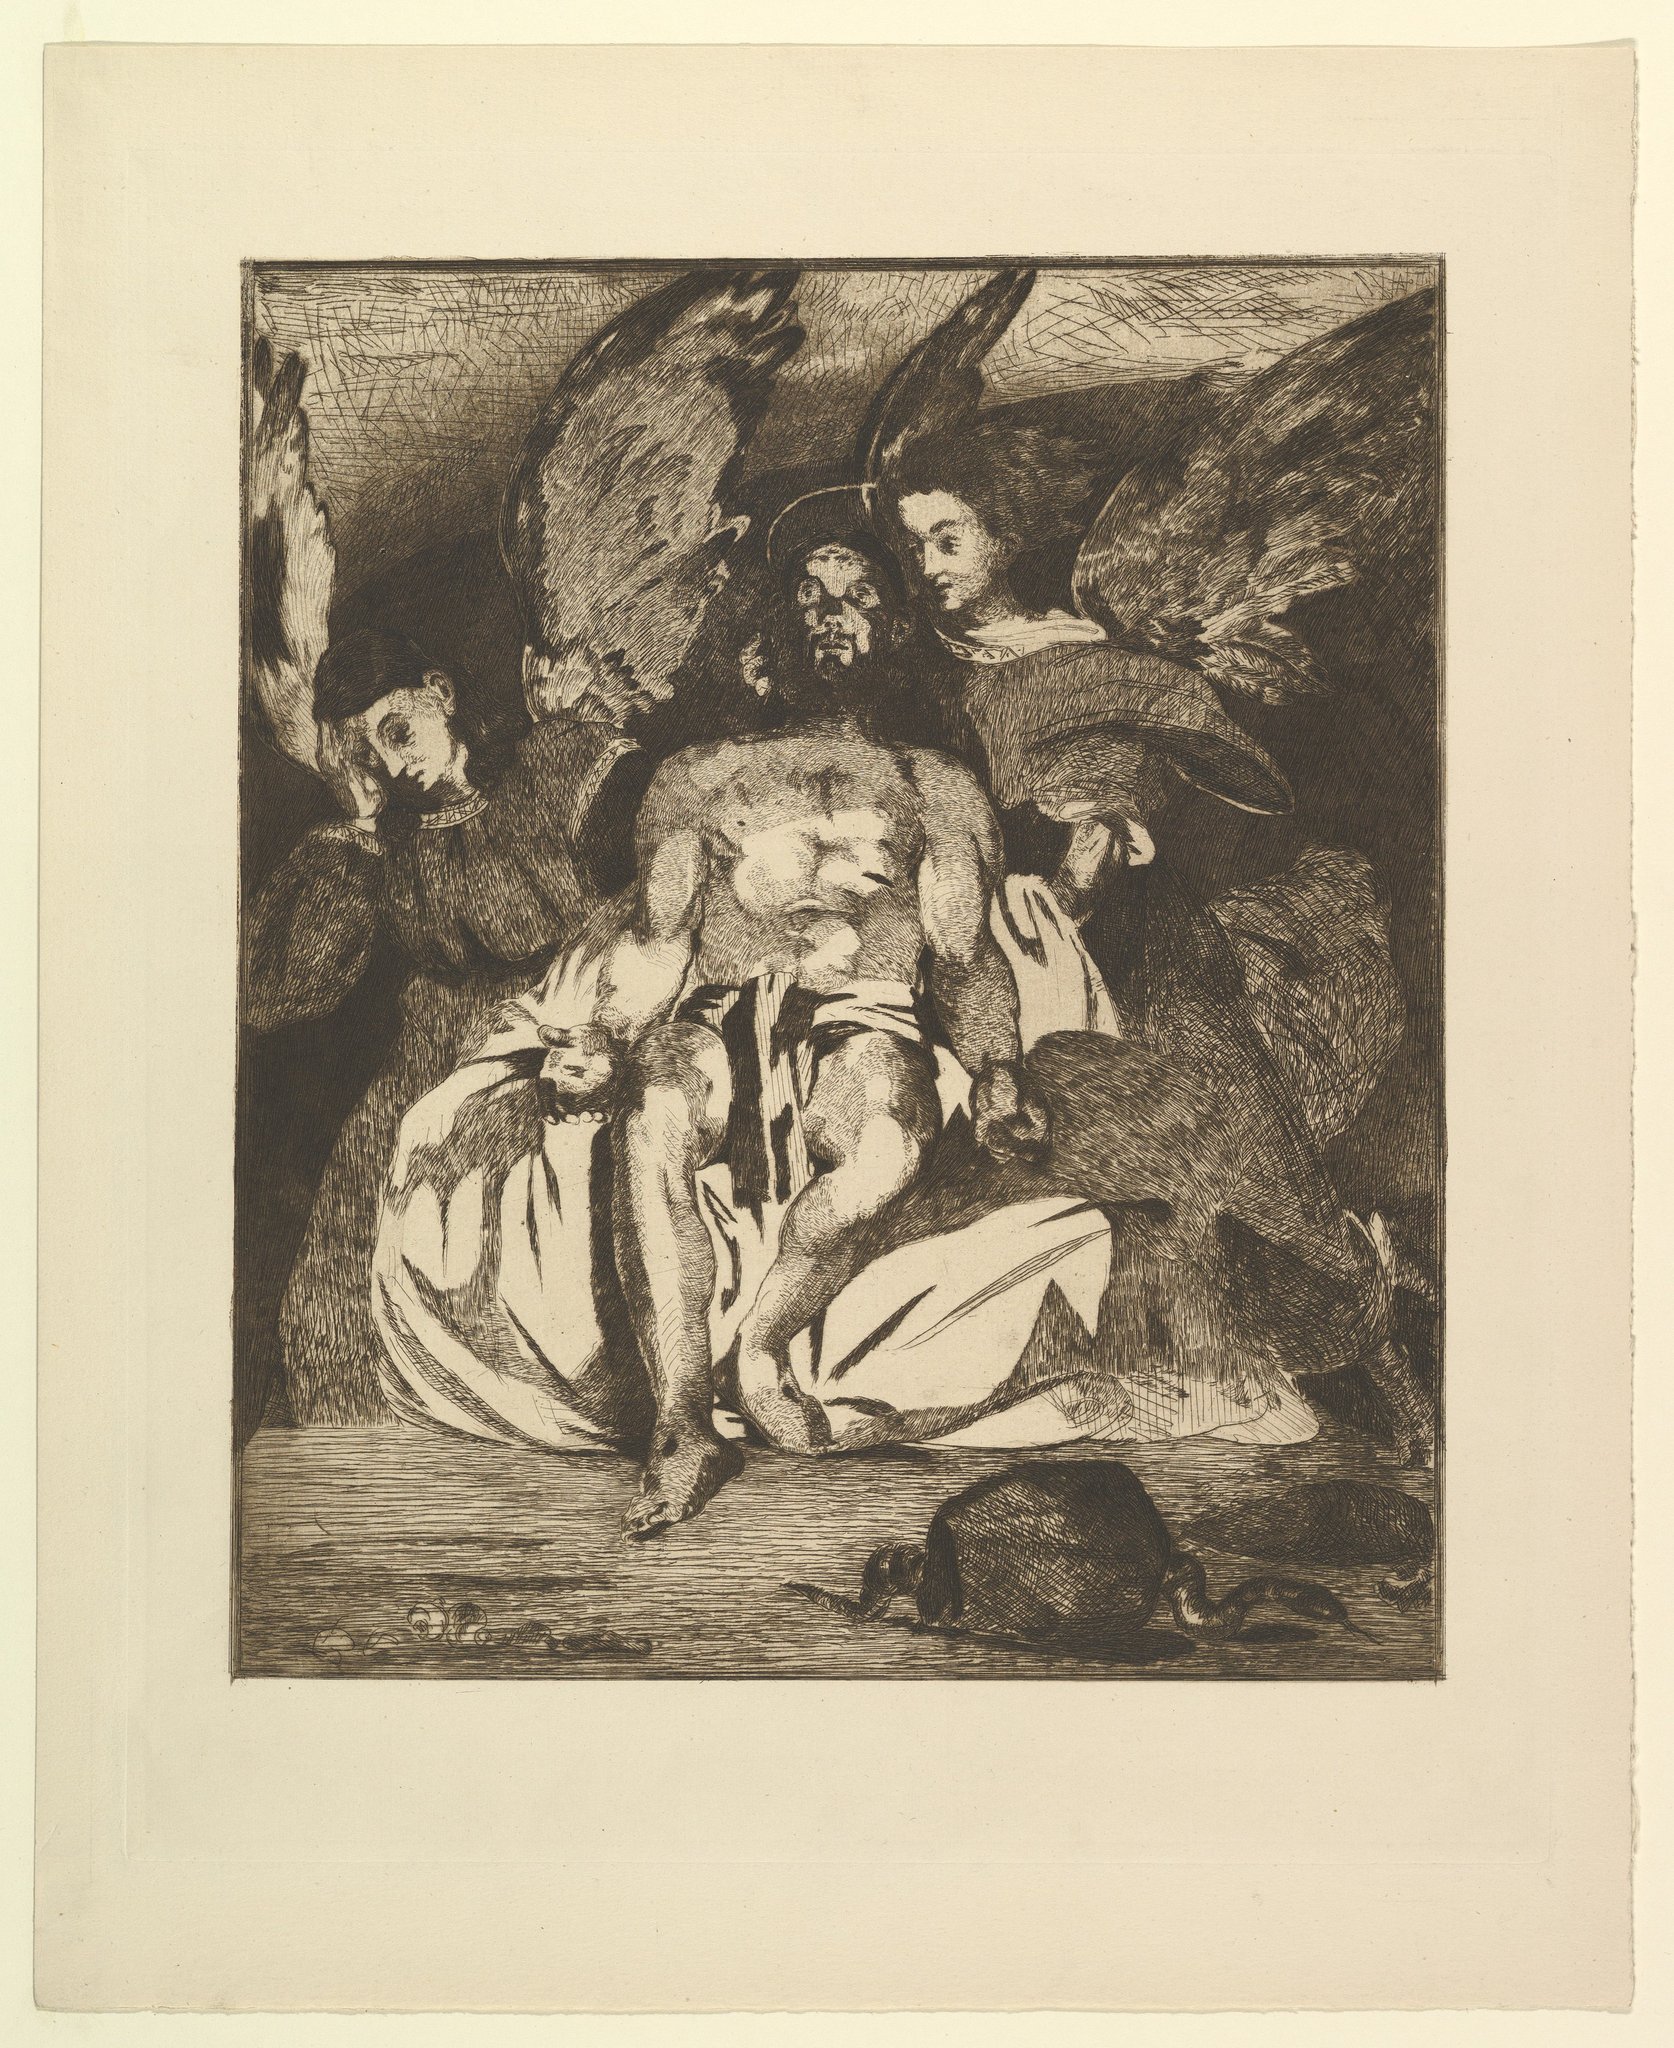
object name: print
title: Dead Christ with Angels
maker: édouard manet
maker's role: artist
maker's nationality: french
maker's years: 1832-1883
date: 1866-1867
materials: ink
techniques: aquatint, etching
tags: angels,christ,death